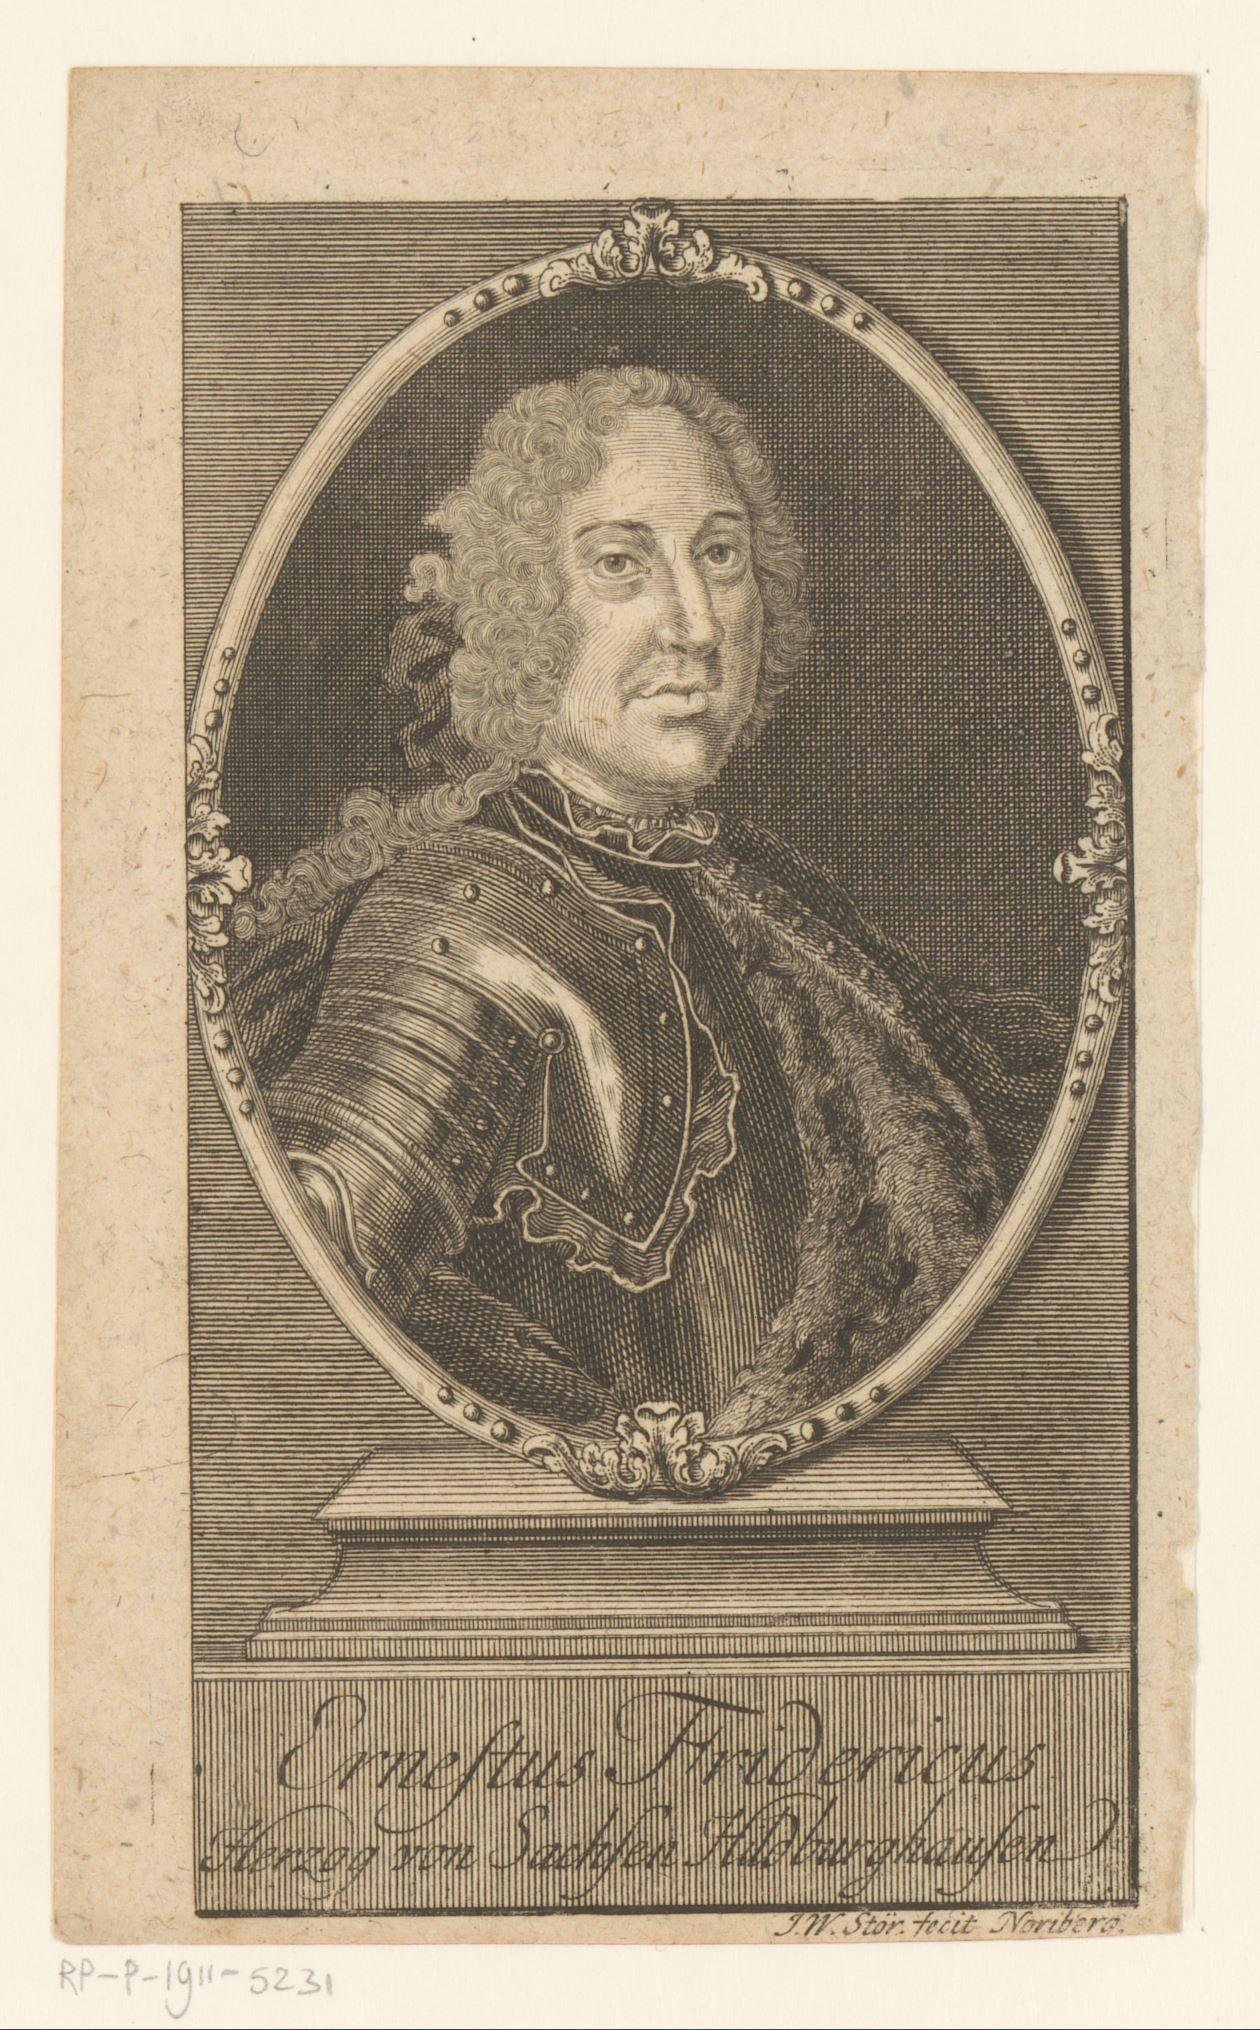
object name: print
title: Portret van Ernst Frederik II van Saksen-Hildburghausen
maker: johann wilhelm stör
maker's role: draughtsman, print maker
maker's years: 1705-1765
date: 1739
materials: paper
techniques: engraving, etching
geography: nuremberg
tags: historical persons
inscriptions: collector's mark: Lugt 2228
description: Prent gebruikt voor de publicatie: Leucht, Christian Leonhard. Europäische Staats-Cantzley. Frankfurt am Main en Leipzig en Neurenberg: s.n., 1739, dl. 74.